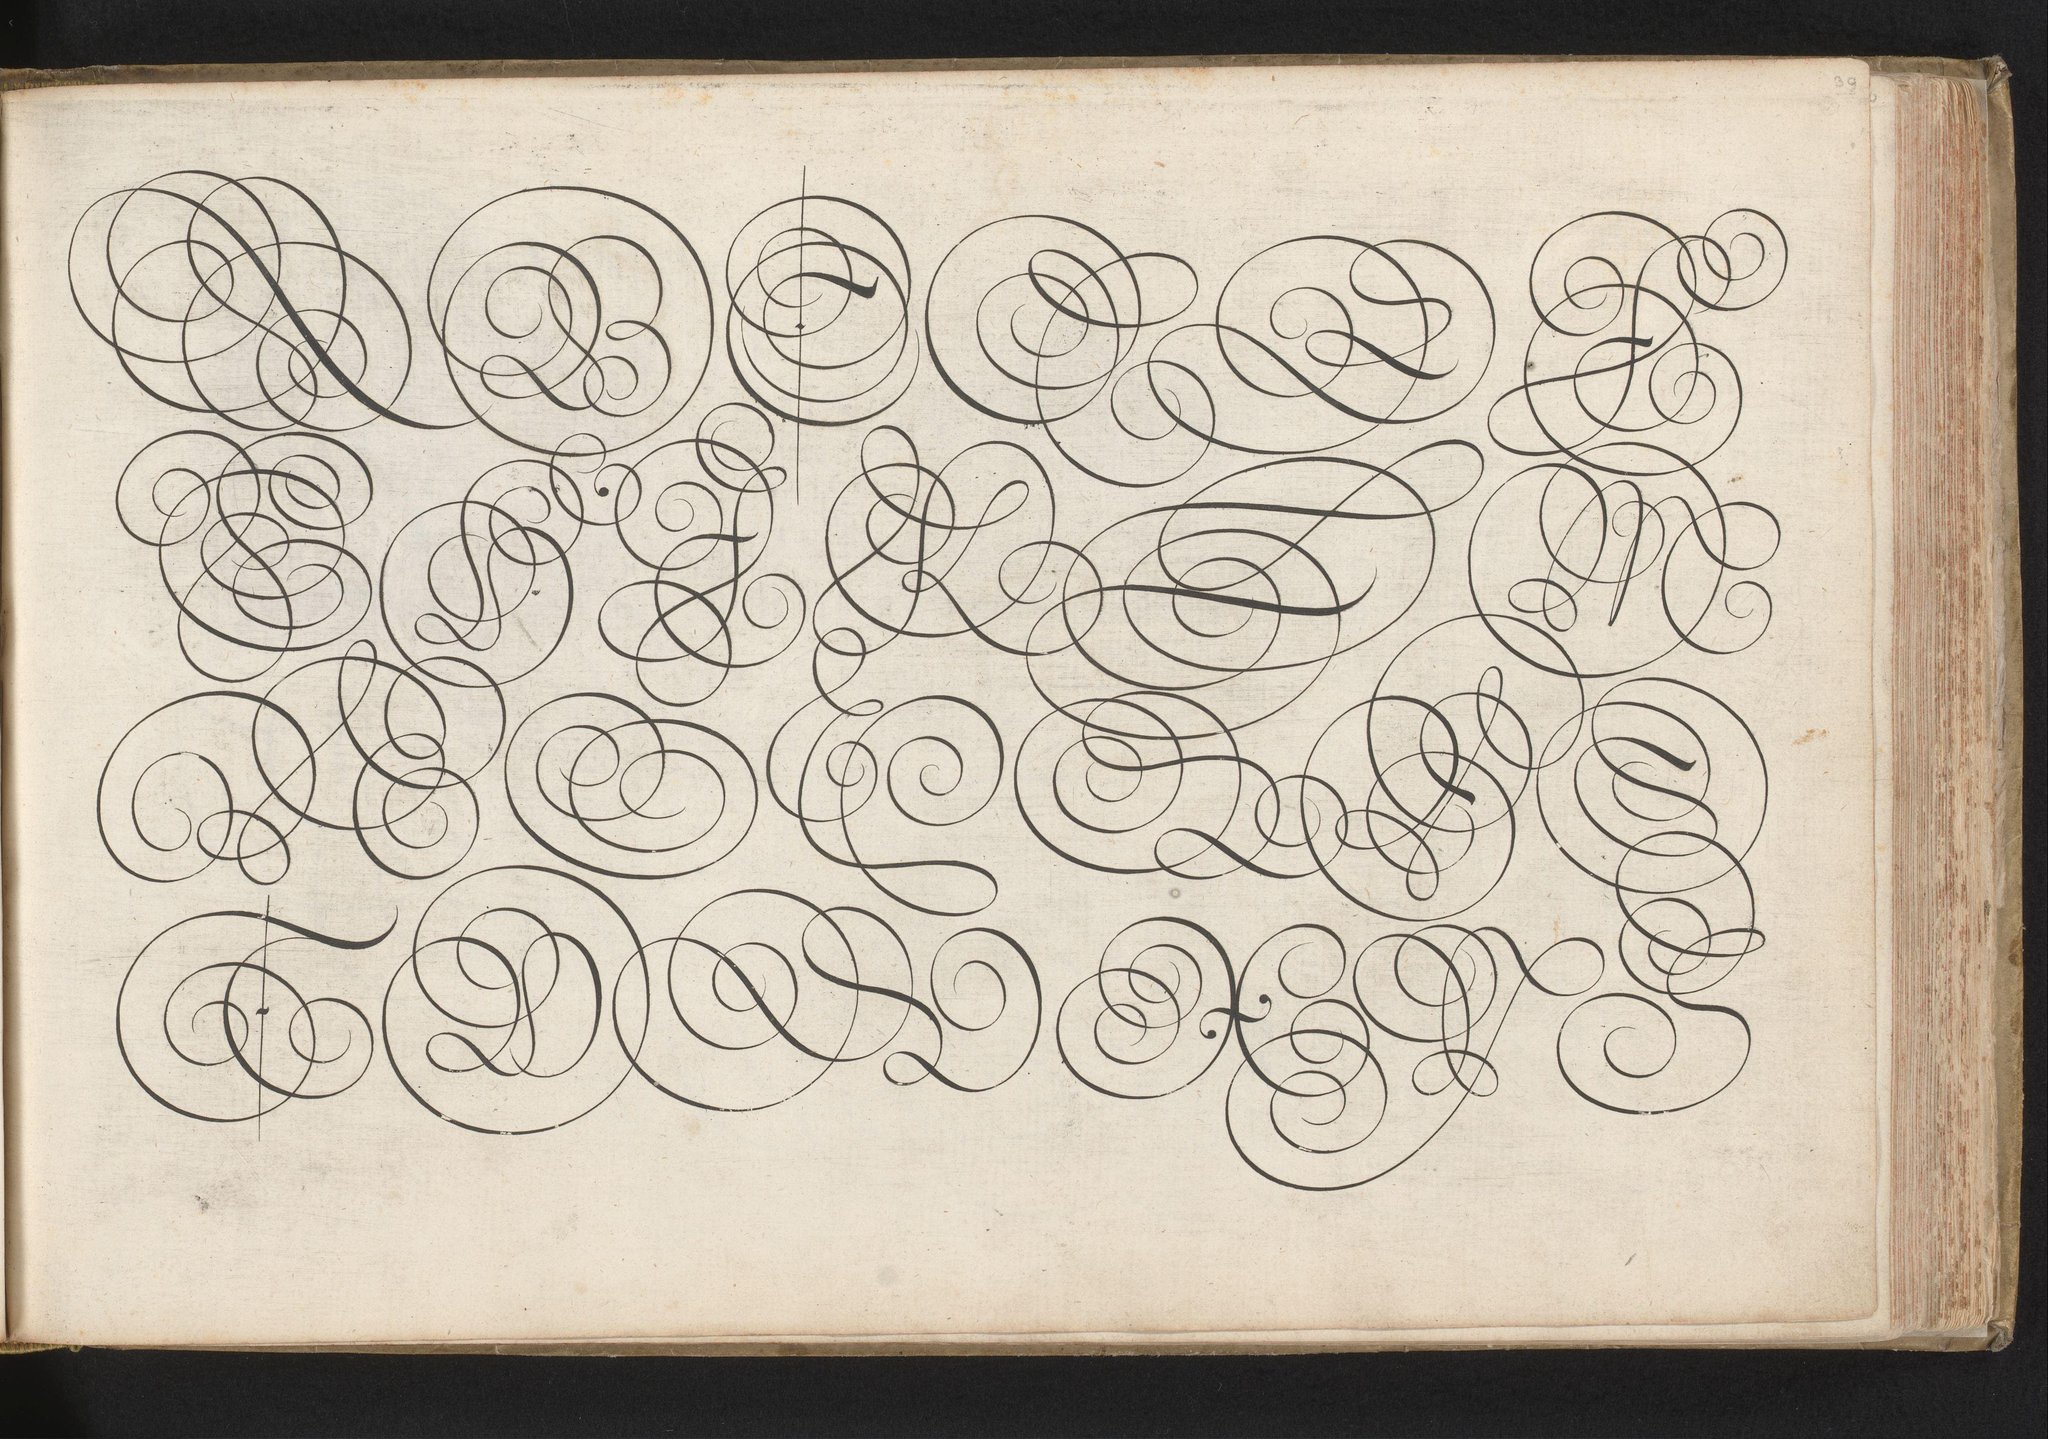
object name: album leaf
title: Spieghel der schrijfkonste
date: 1605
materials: paper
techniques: engraving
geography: rotterdam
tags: calligraphy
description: Schrijfvoorbeeld met het alfabet in vier regels kapitalen. De prent maakt deel uit van een album.